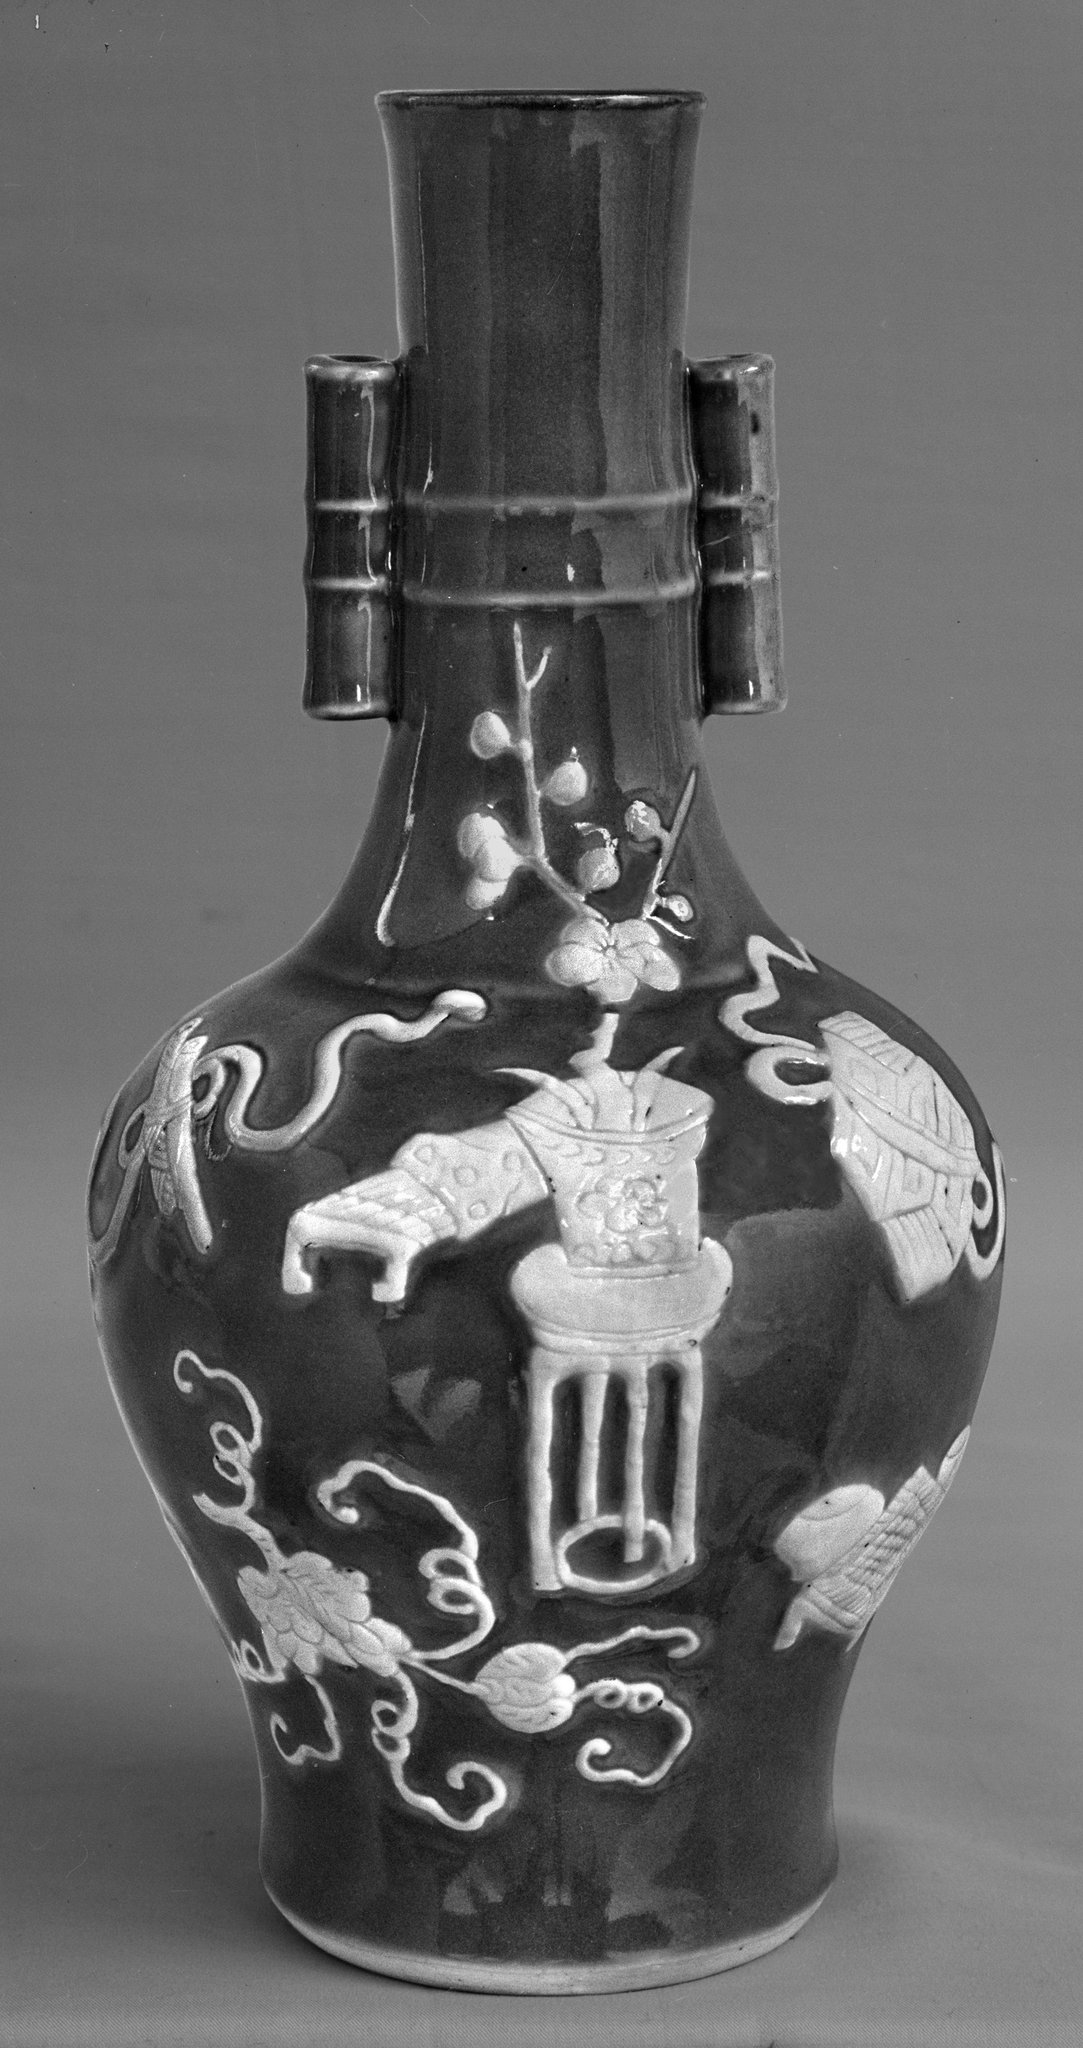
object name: vase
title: Vase with scholar's objects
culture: chinese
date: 1801-1900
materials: glaze, porcelain